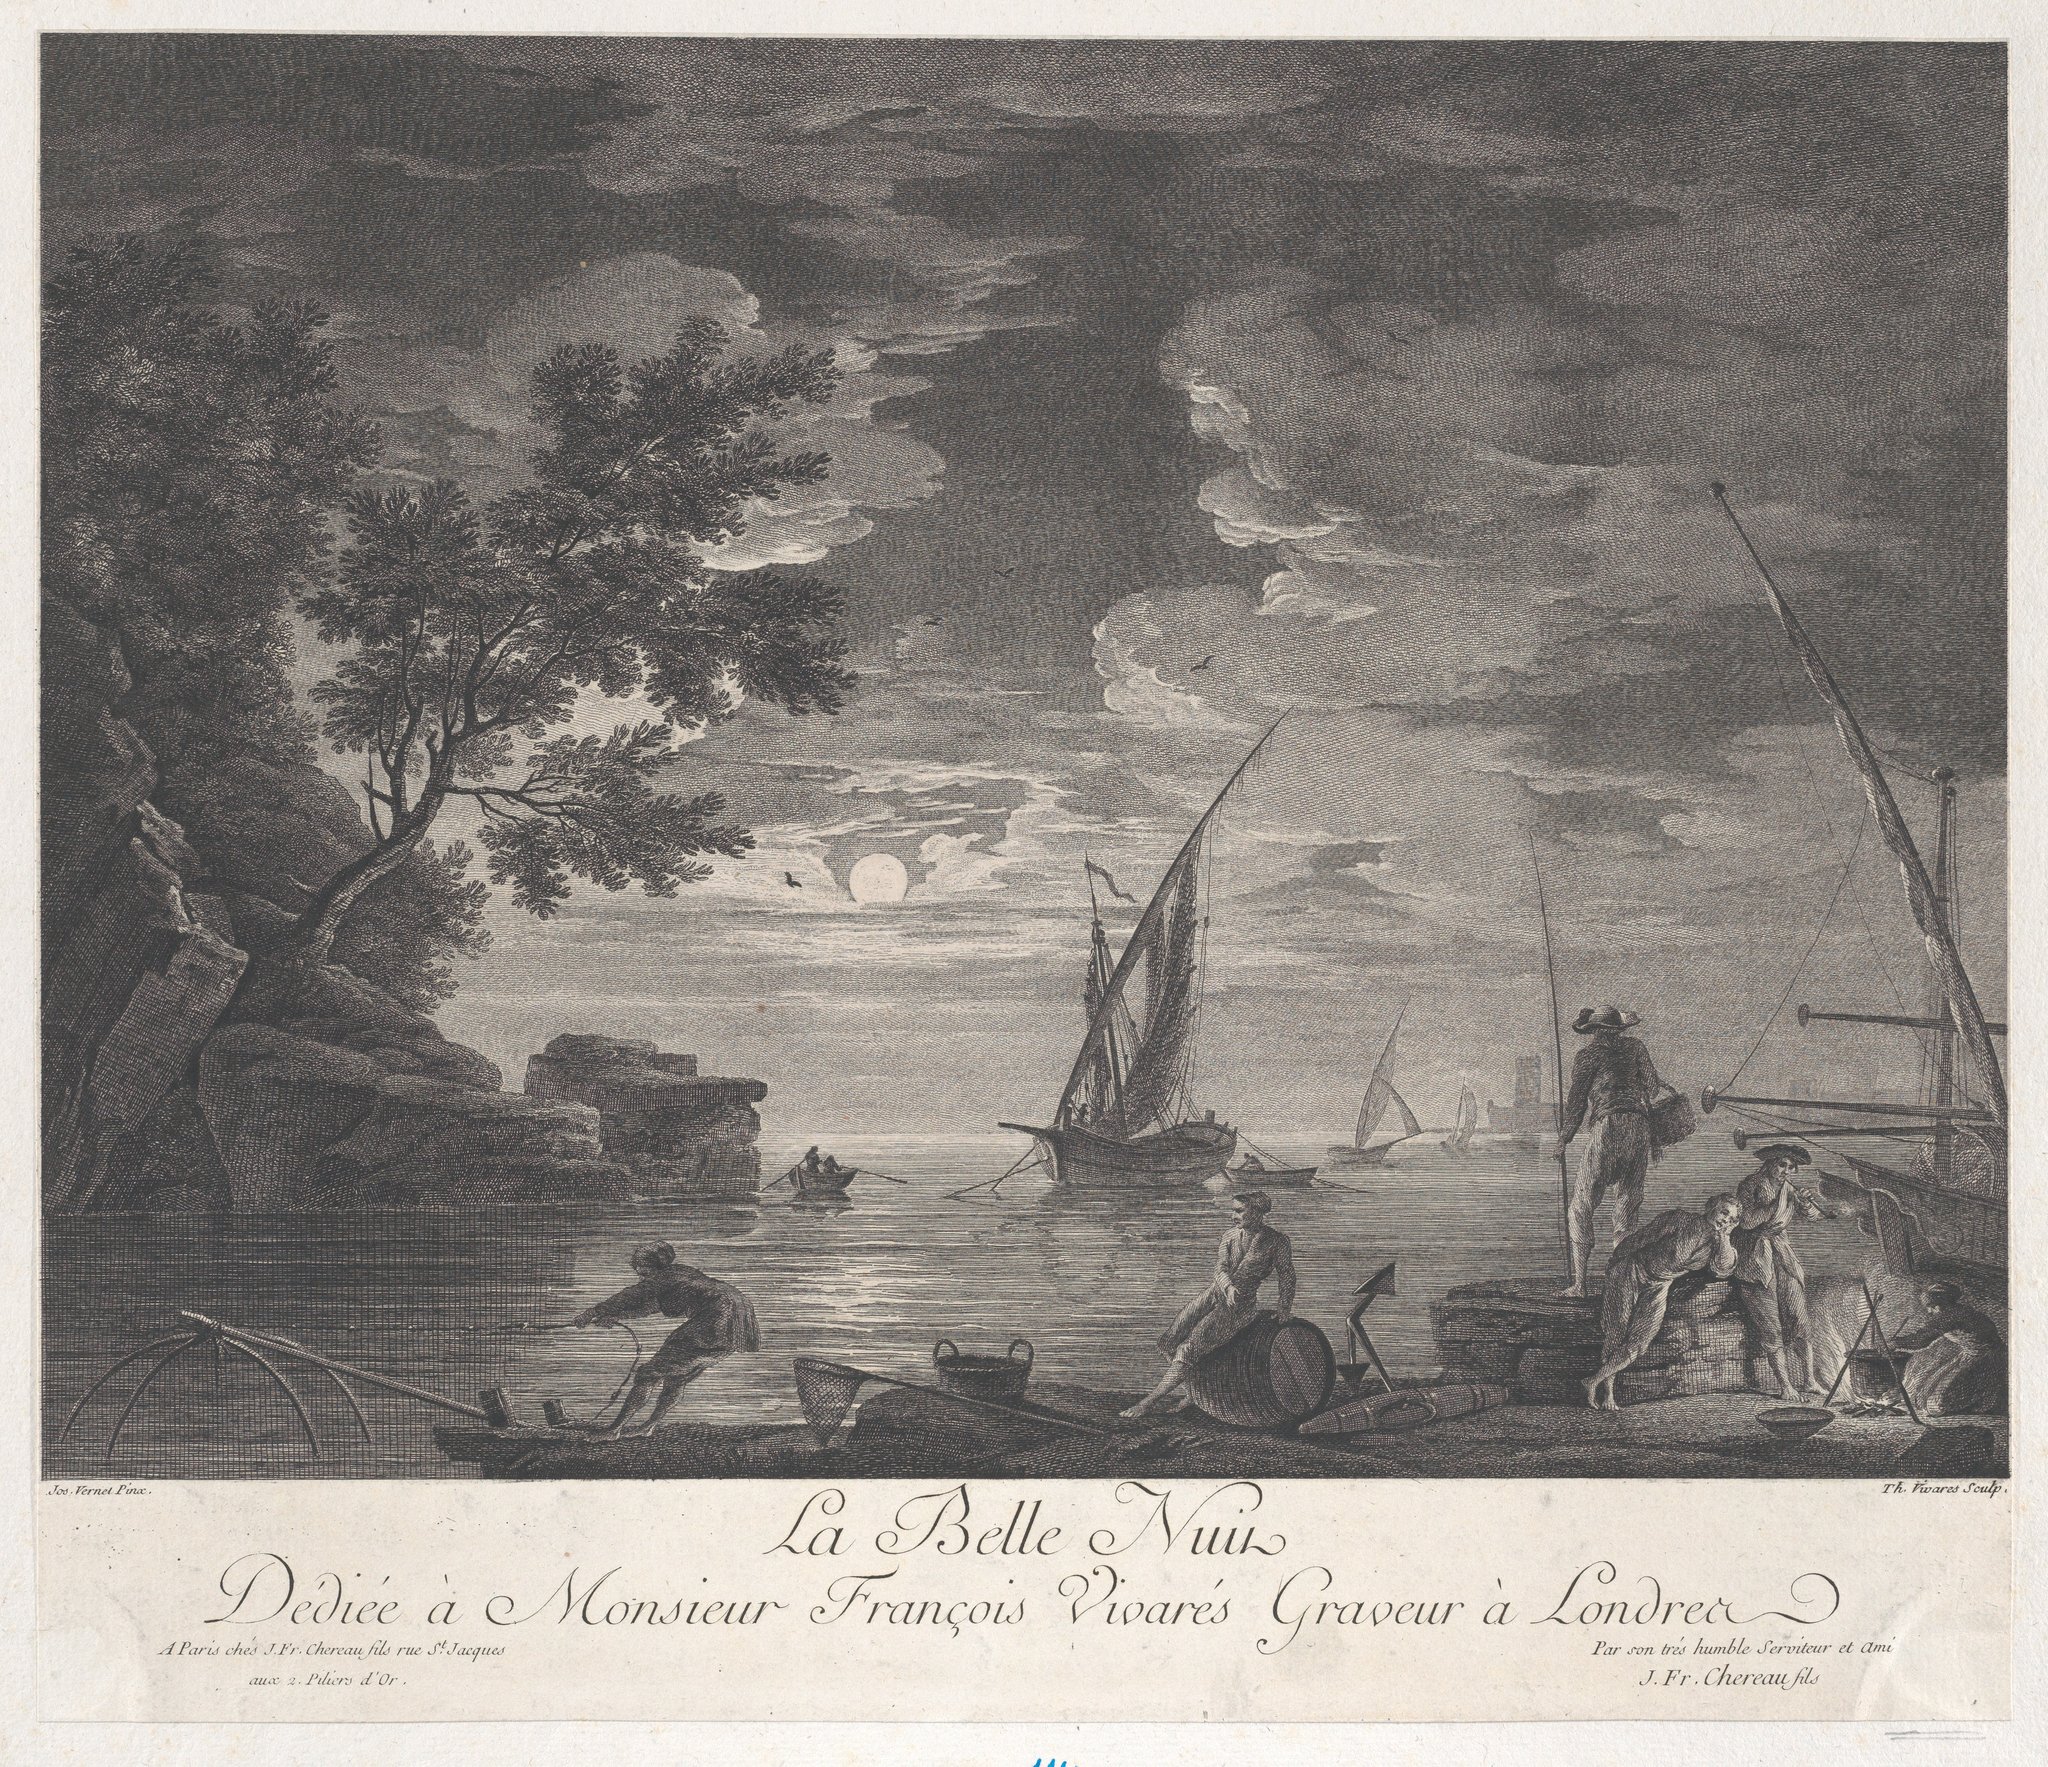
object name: print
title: The Beautiful Night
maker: joseph vernet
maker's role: artist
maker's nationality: french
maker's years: 1714-1789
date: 1750-1780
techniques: engraving